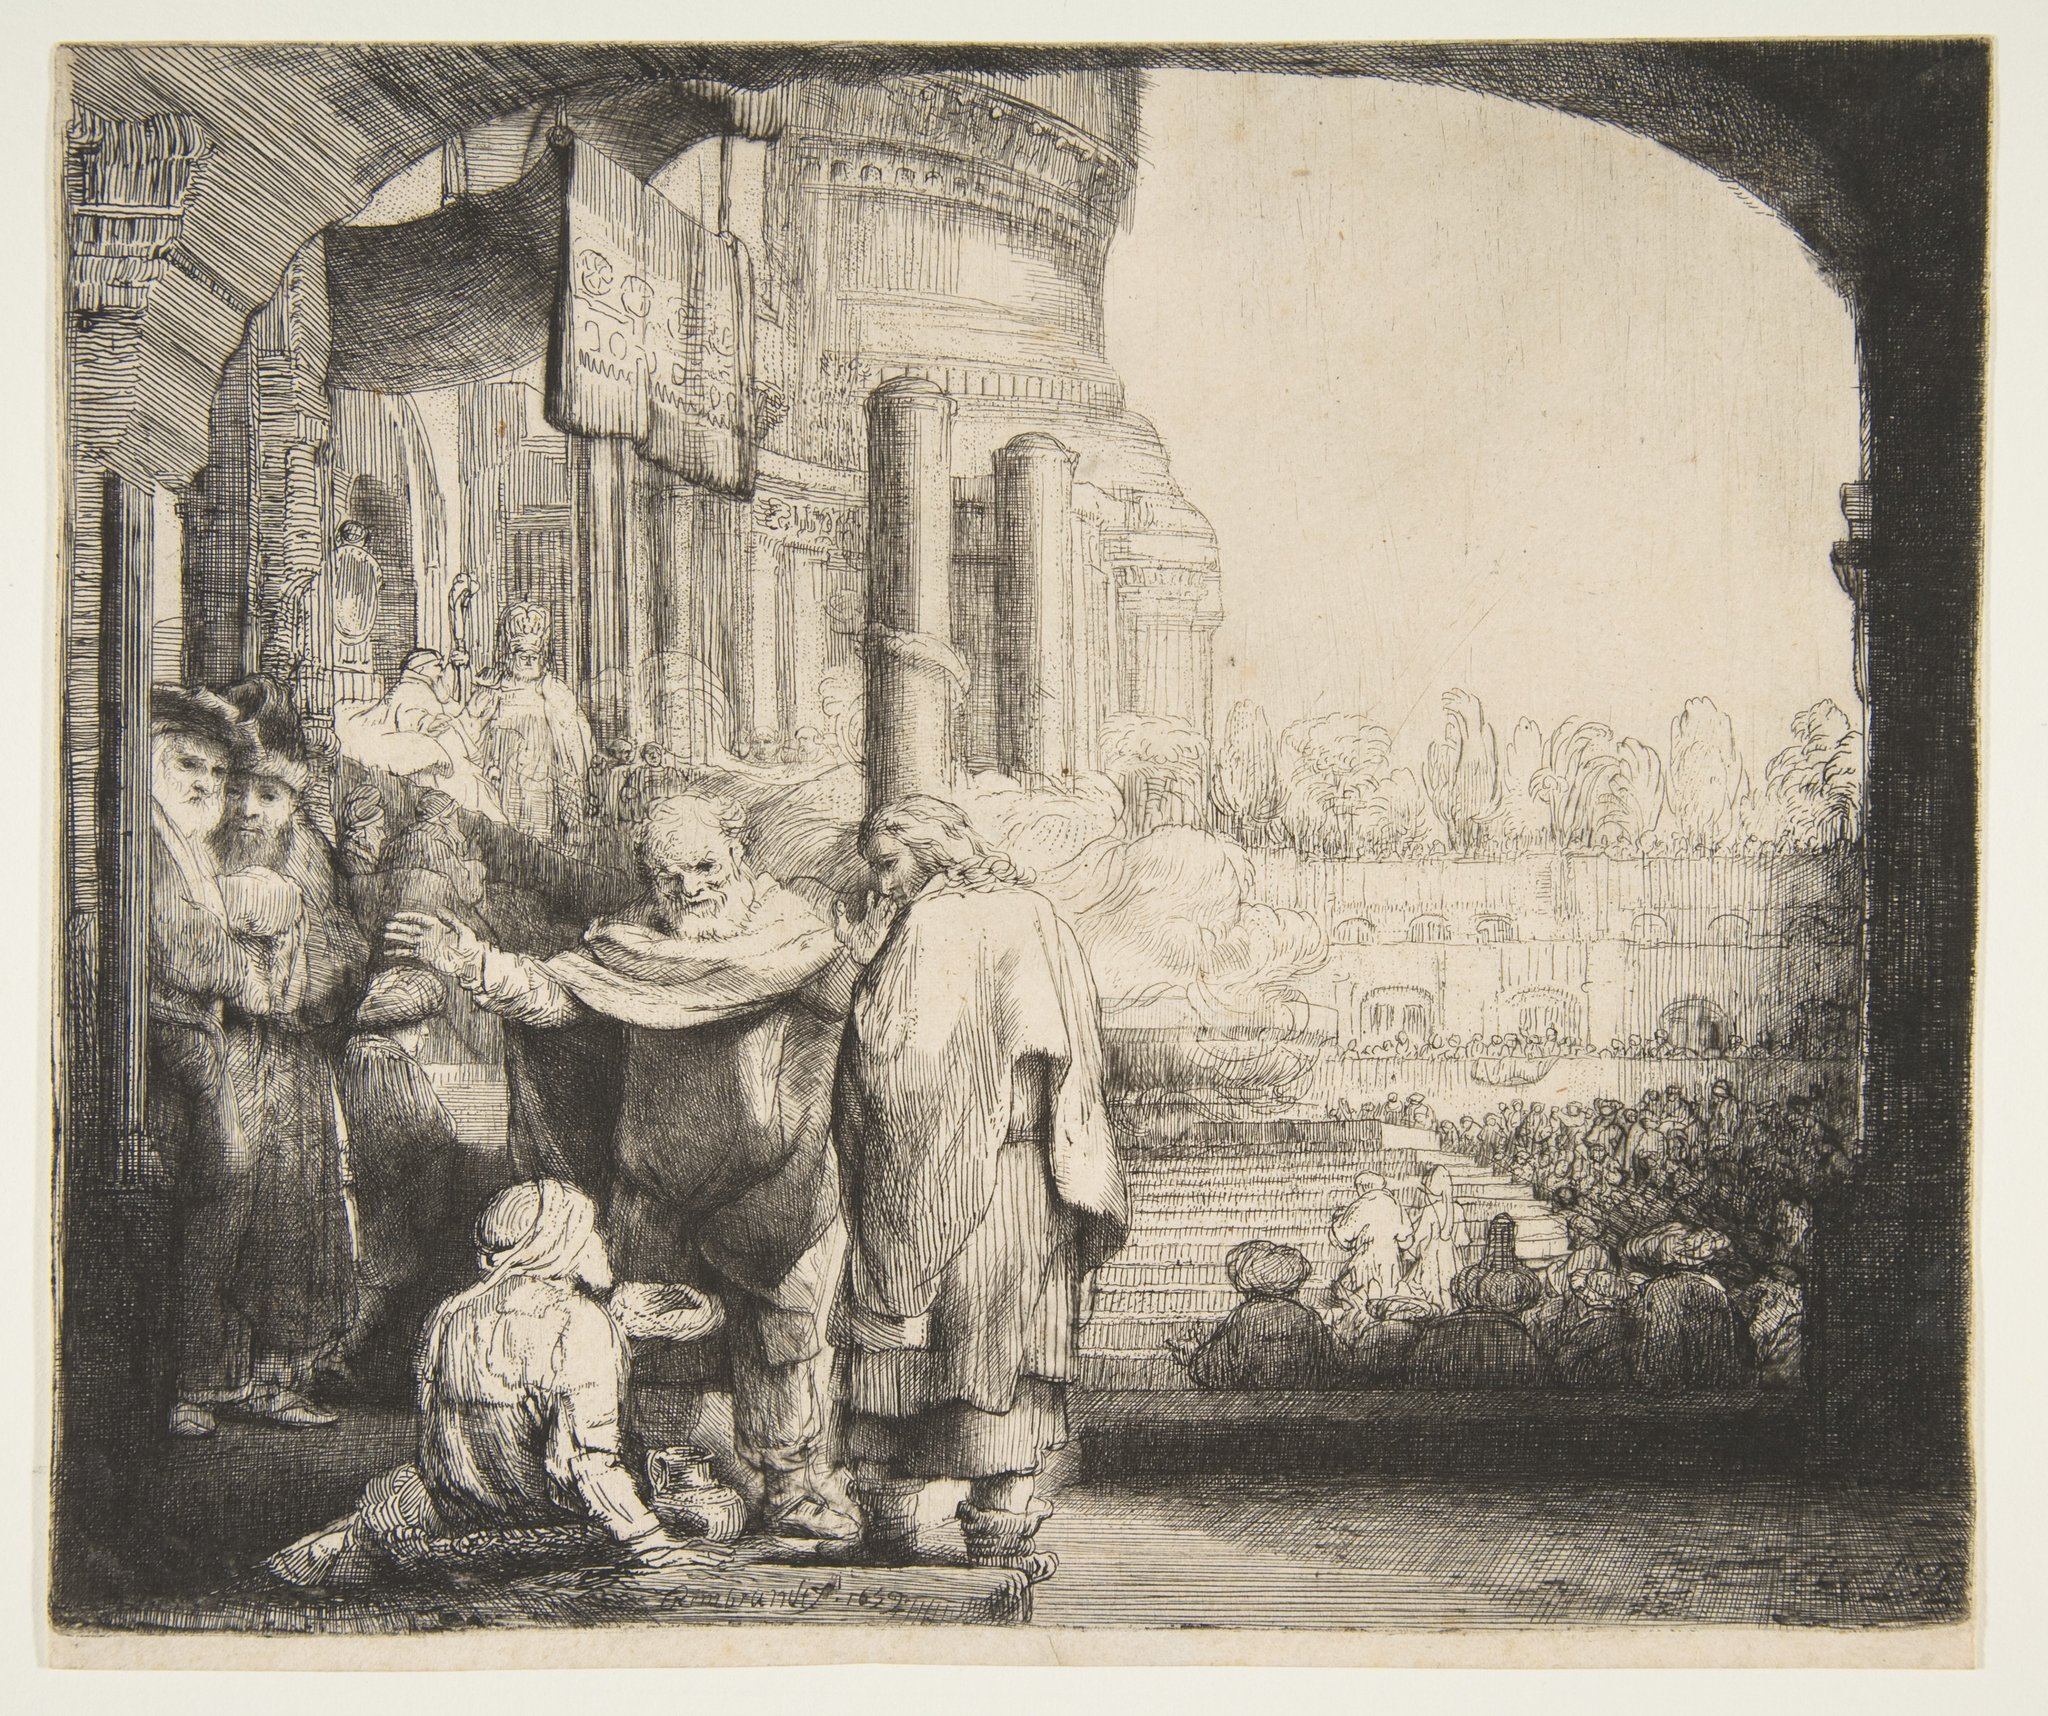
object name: print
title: Peter and John Healing the Cripple at the Gate of the Temple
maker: rembrandt van rijn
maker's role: artist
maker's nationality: dutch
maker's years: 1606-1669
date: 1659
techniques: drypoint, engraving, etching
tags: gates,temples,men,saint peter